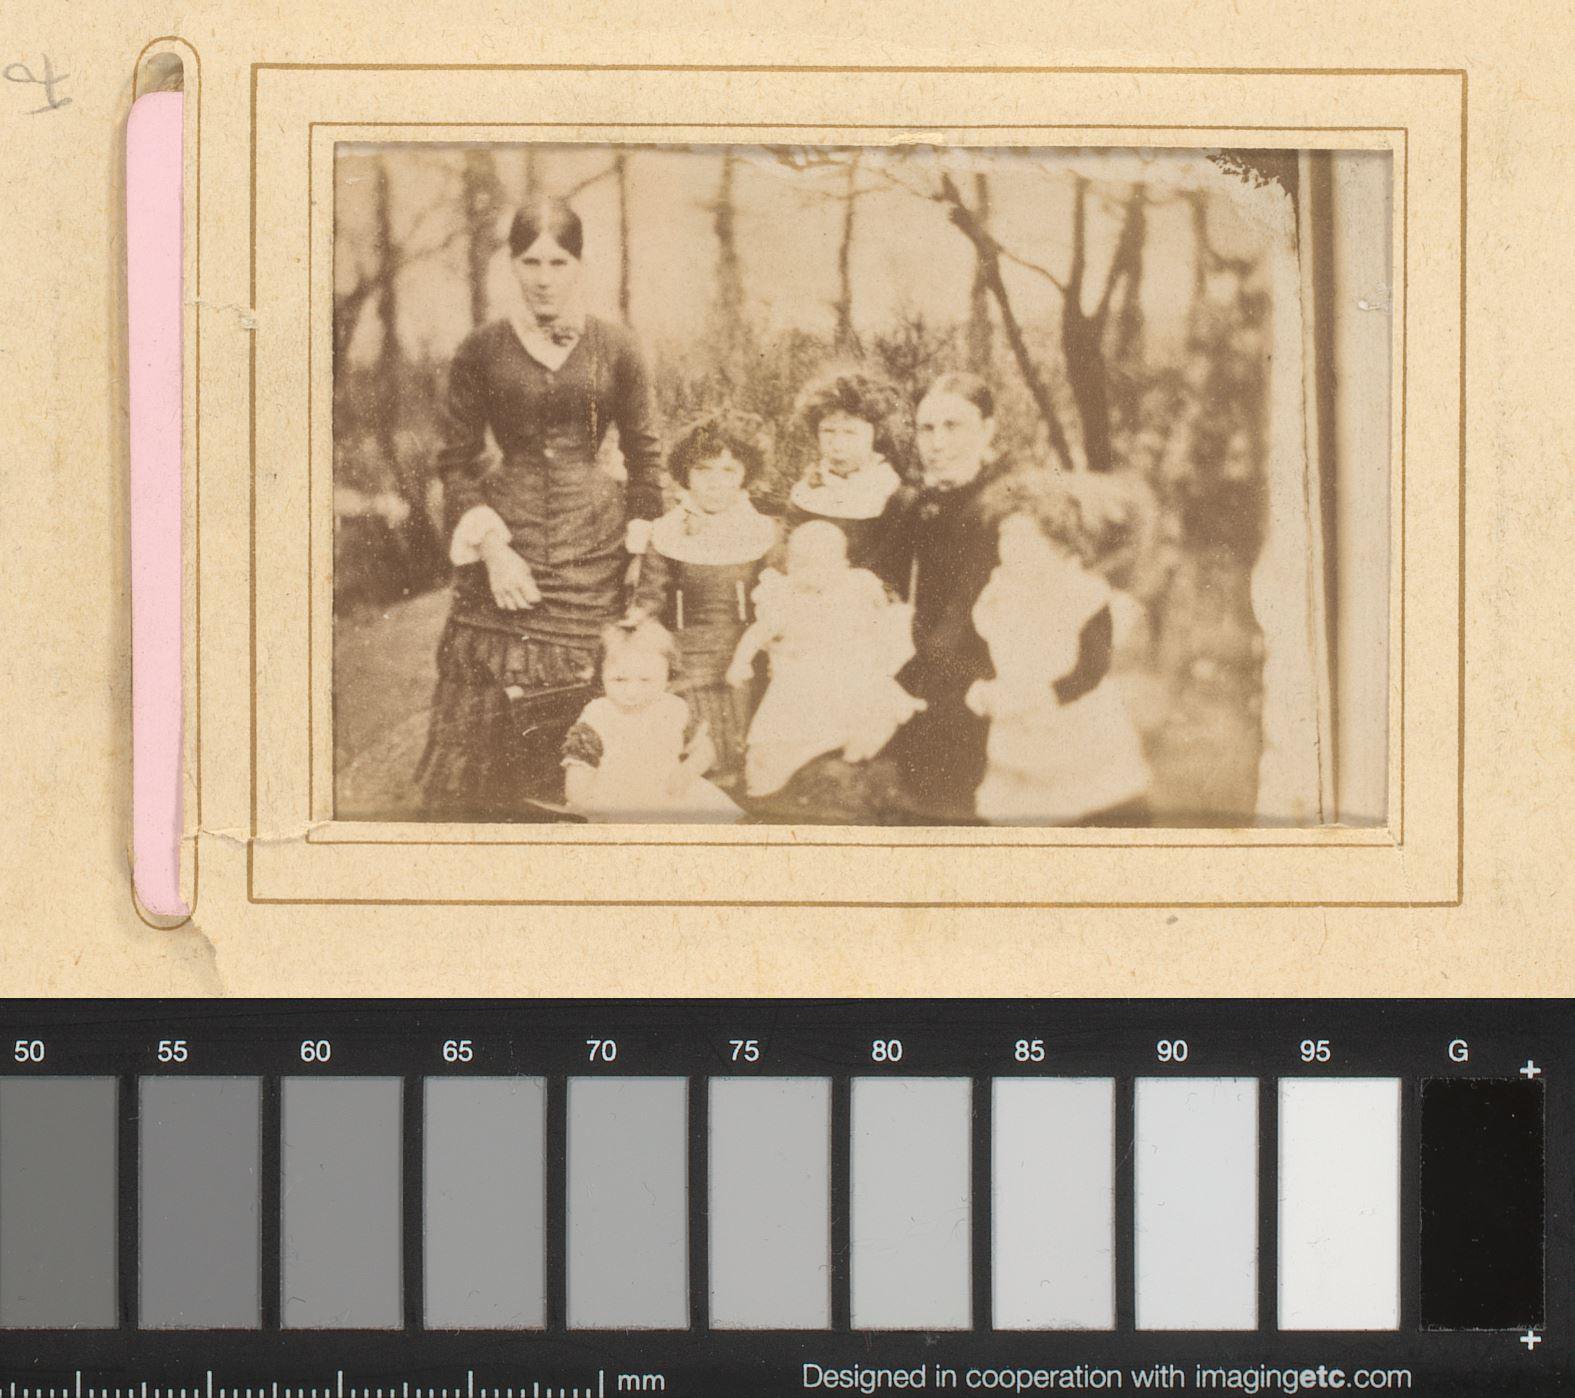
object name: photograph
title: Groepsportret van twee vrouwen en vijf meisjes in het bos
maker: Anonymous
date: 1850-1900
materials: cardboard, photographic support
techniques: albumen print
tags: adult woman (+ two persons), anonymous historical persons portrayed in a group, in a group-portrait